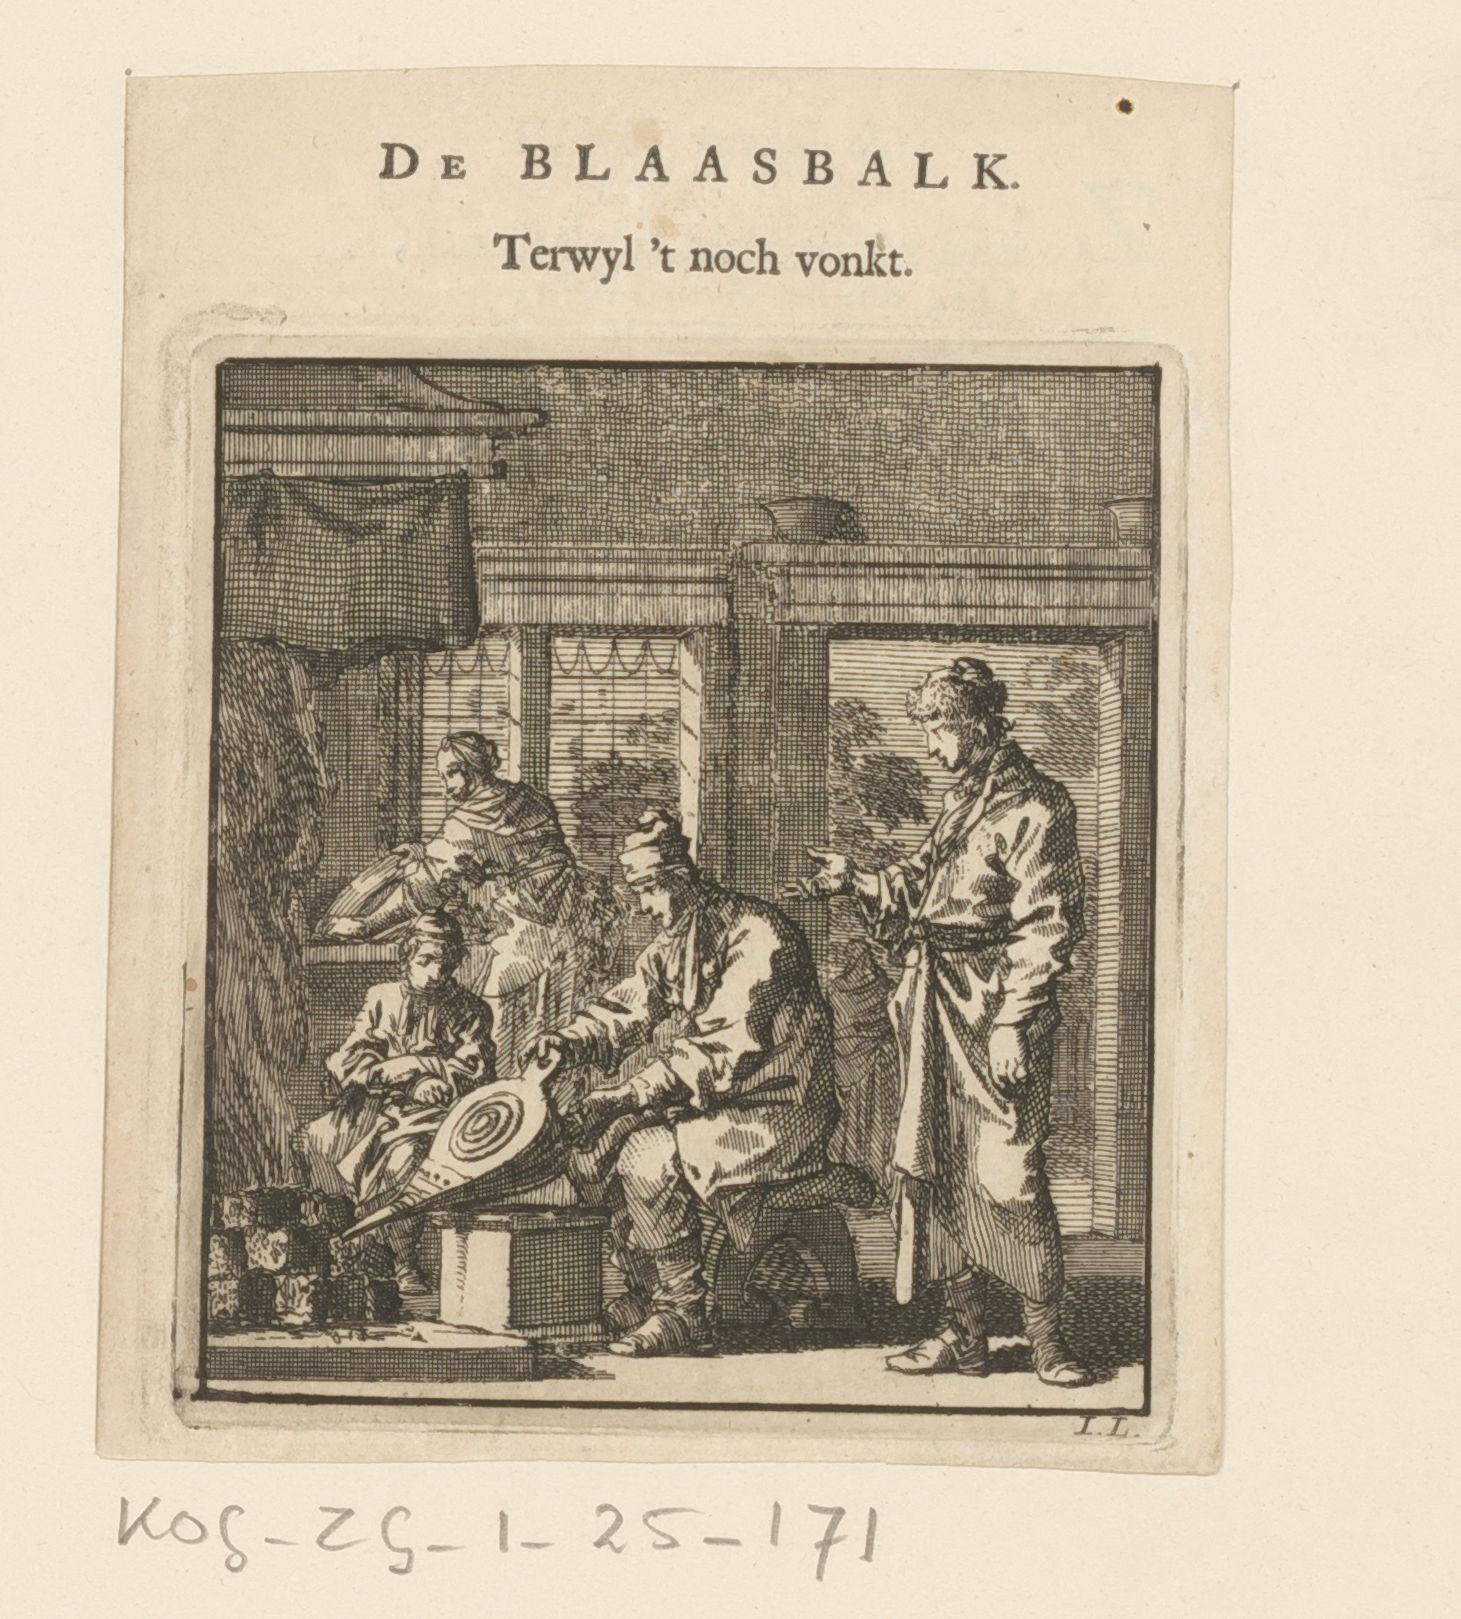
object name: book illustration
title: Man stookt het vuur op met een blaasbalg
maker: jan luyken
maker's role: draughtsman, print maker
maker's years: 1649-1712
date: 1711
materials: paper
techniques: etching, letterpress printing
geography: amsterdam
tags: bellows, washing up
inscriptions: collector's mark: Lugt 1641, stamp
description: Prent uit: Luyken, Jan. Het leerzaam huisraad, vertoond in vyftig konstige figuuren, met godlyke spreuken en stichtelyke verzen. Amsterdam: weduwe Pieter Arentsz. II en Cornelis van der Sys, 1711, p. 92.